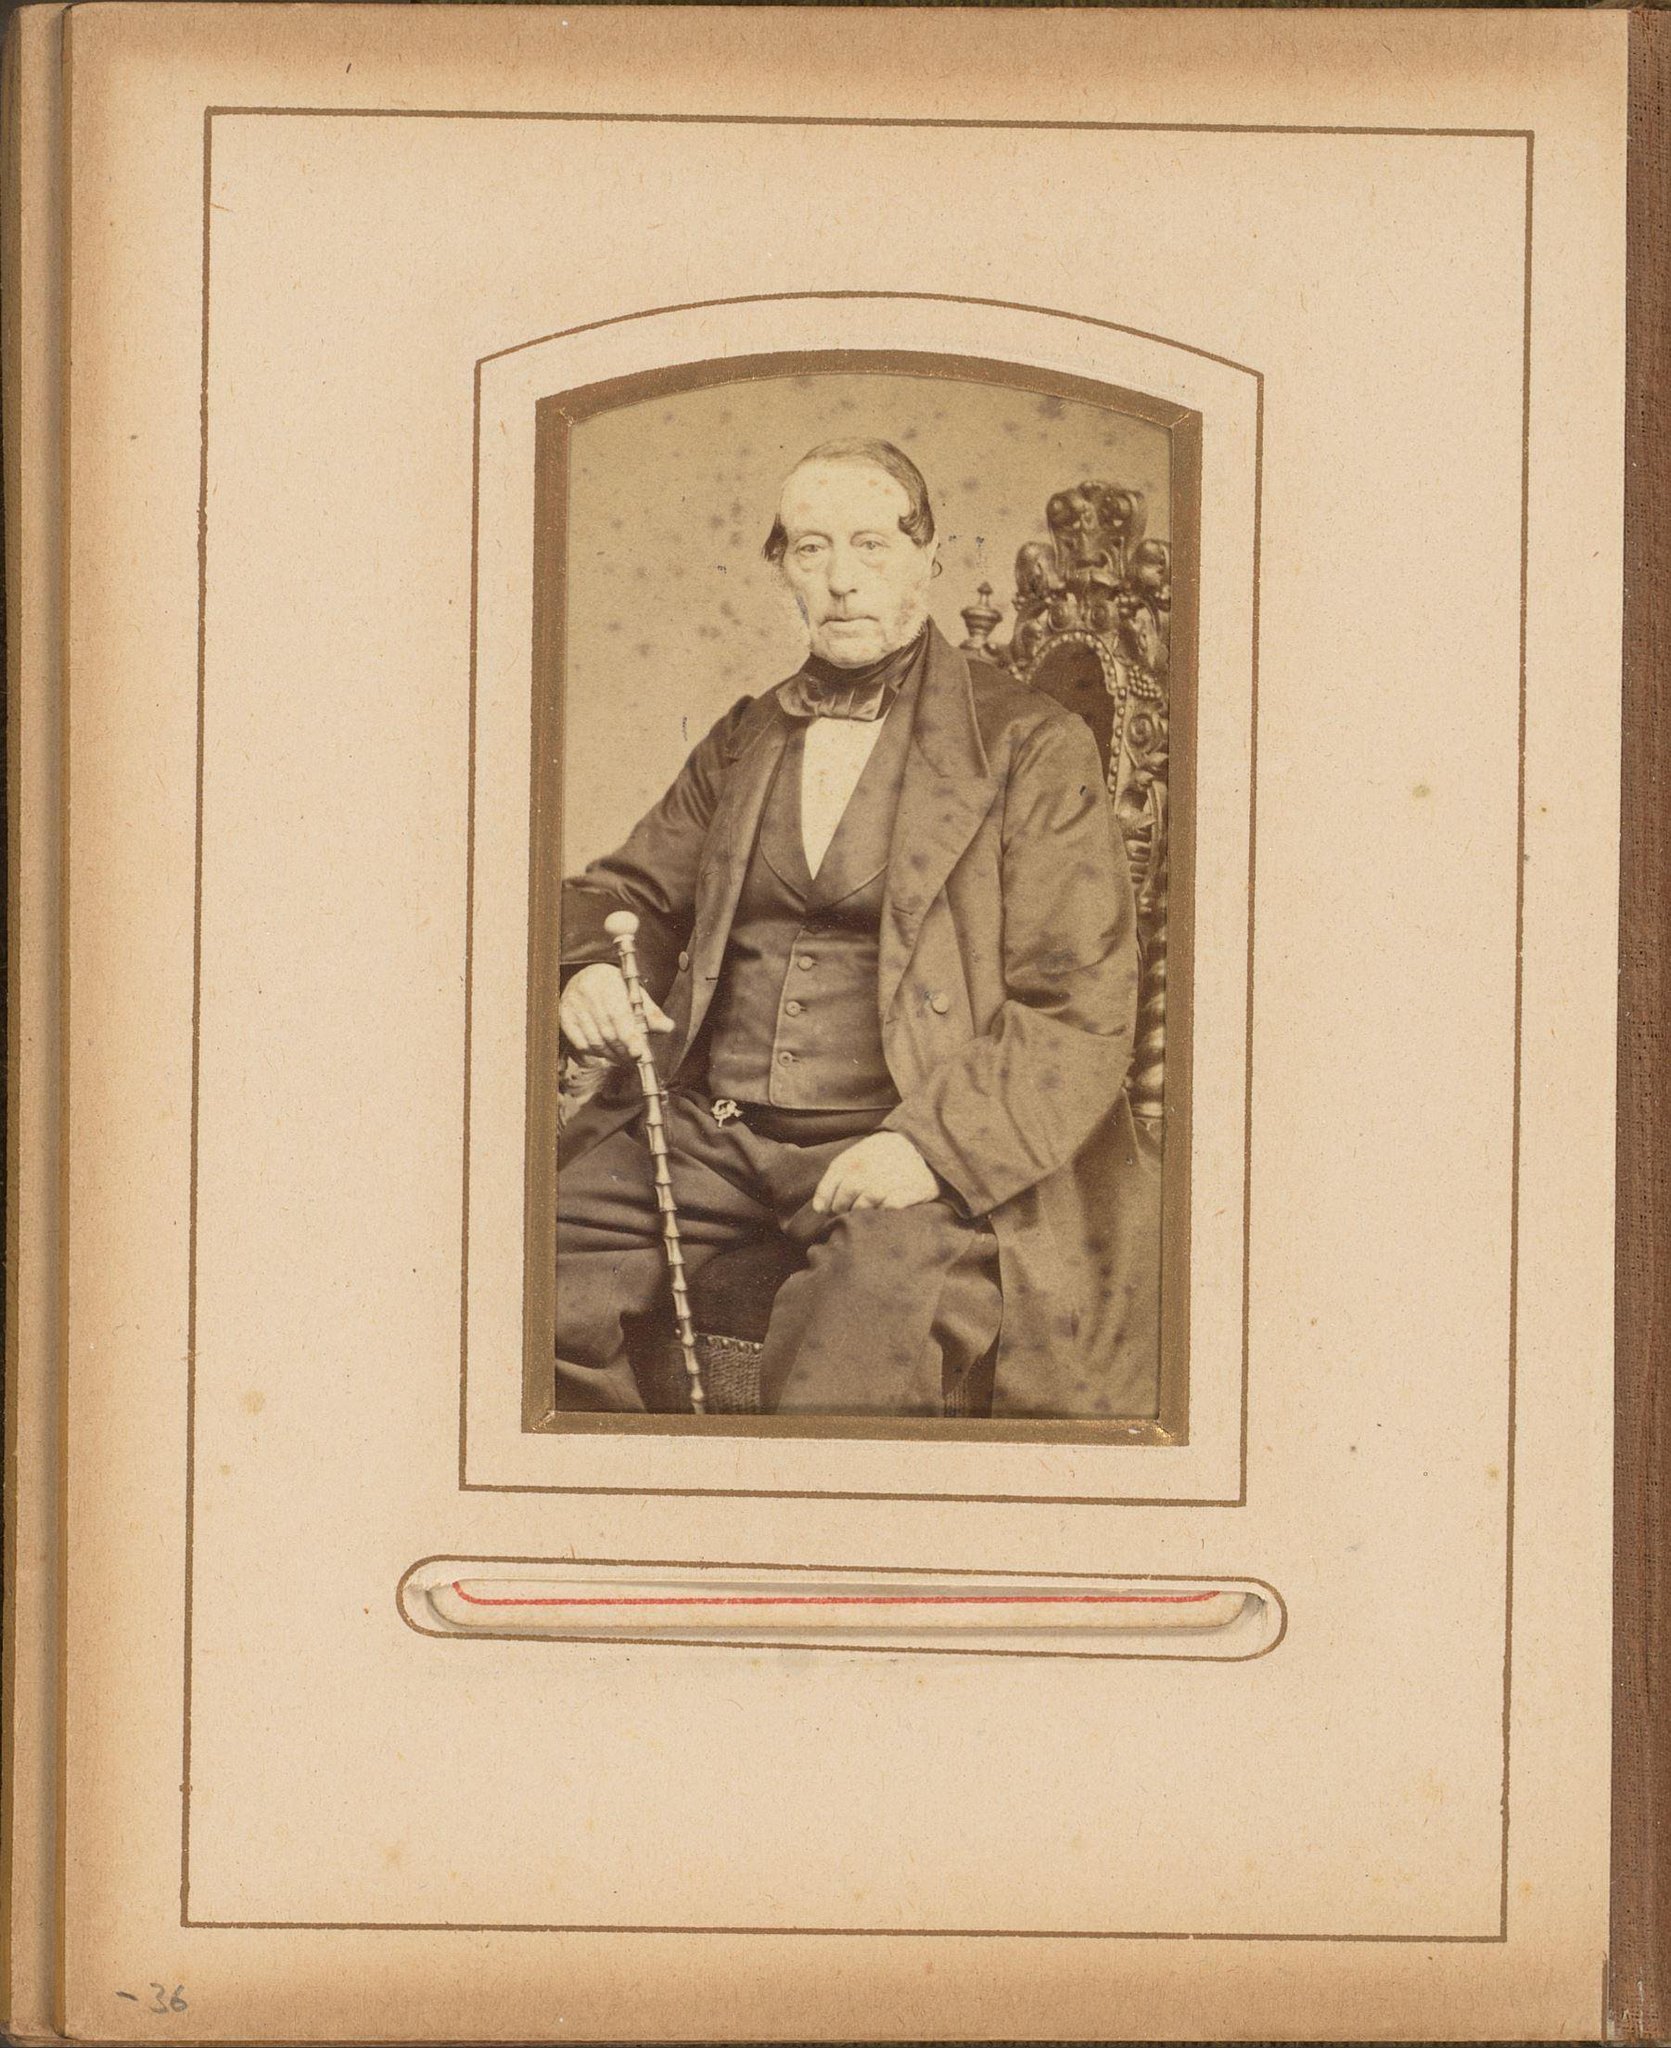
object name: photograph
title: Portret van een man met wandelstok, mogelijk lid van de familie Beucker Andreae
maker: Anonymous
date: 1854-1885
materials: cardboard, paper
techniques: albumen print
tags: adult man, anonymous historical person portrayed